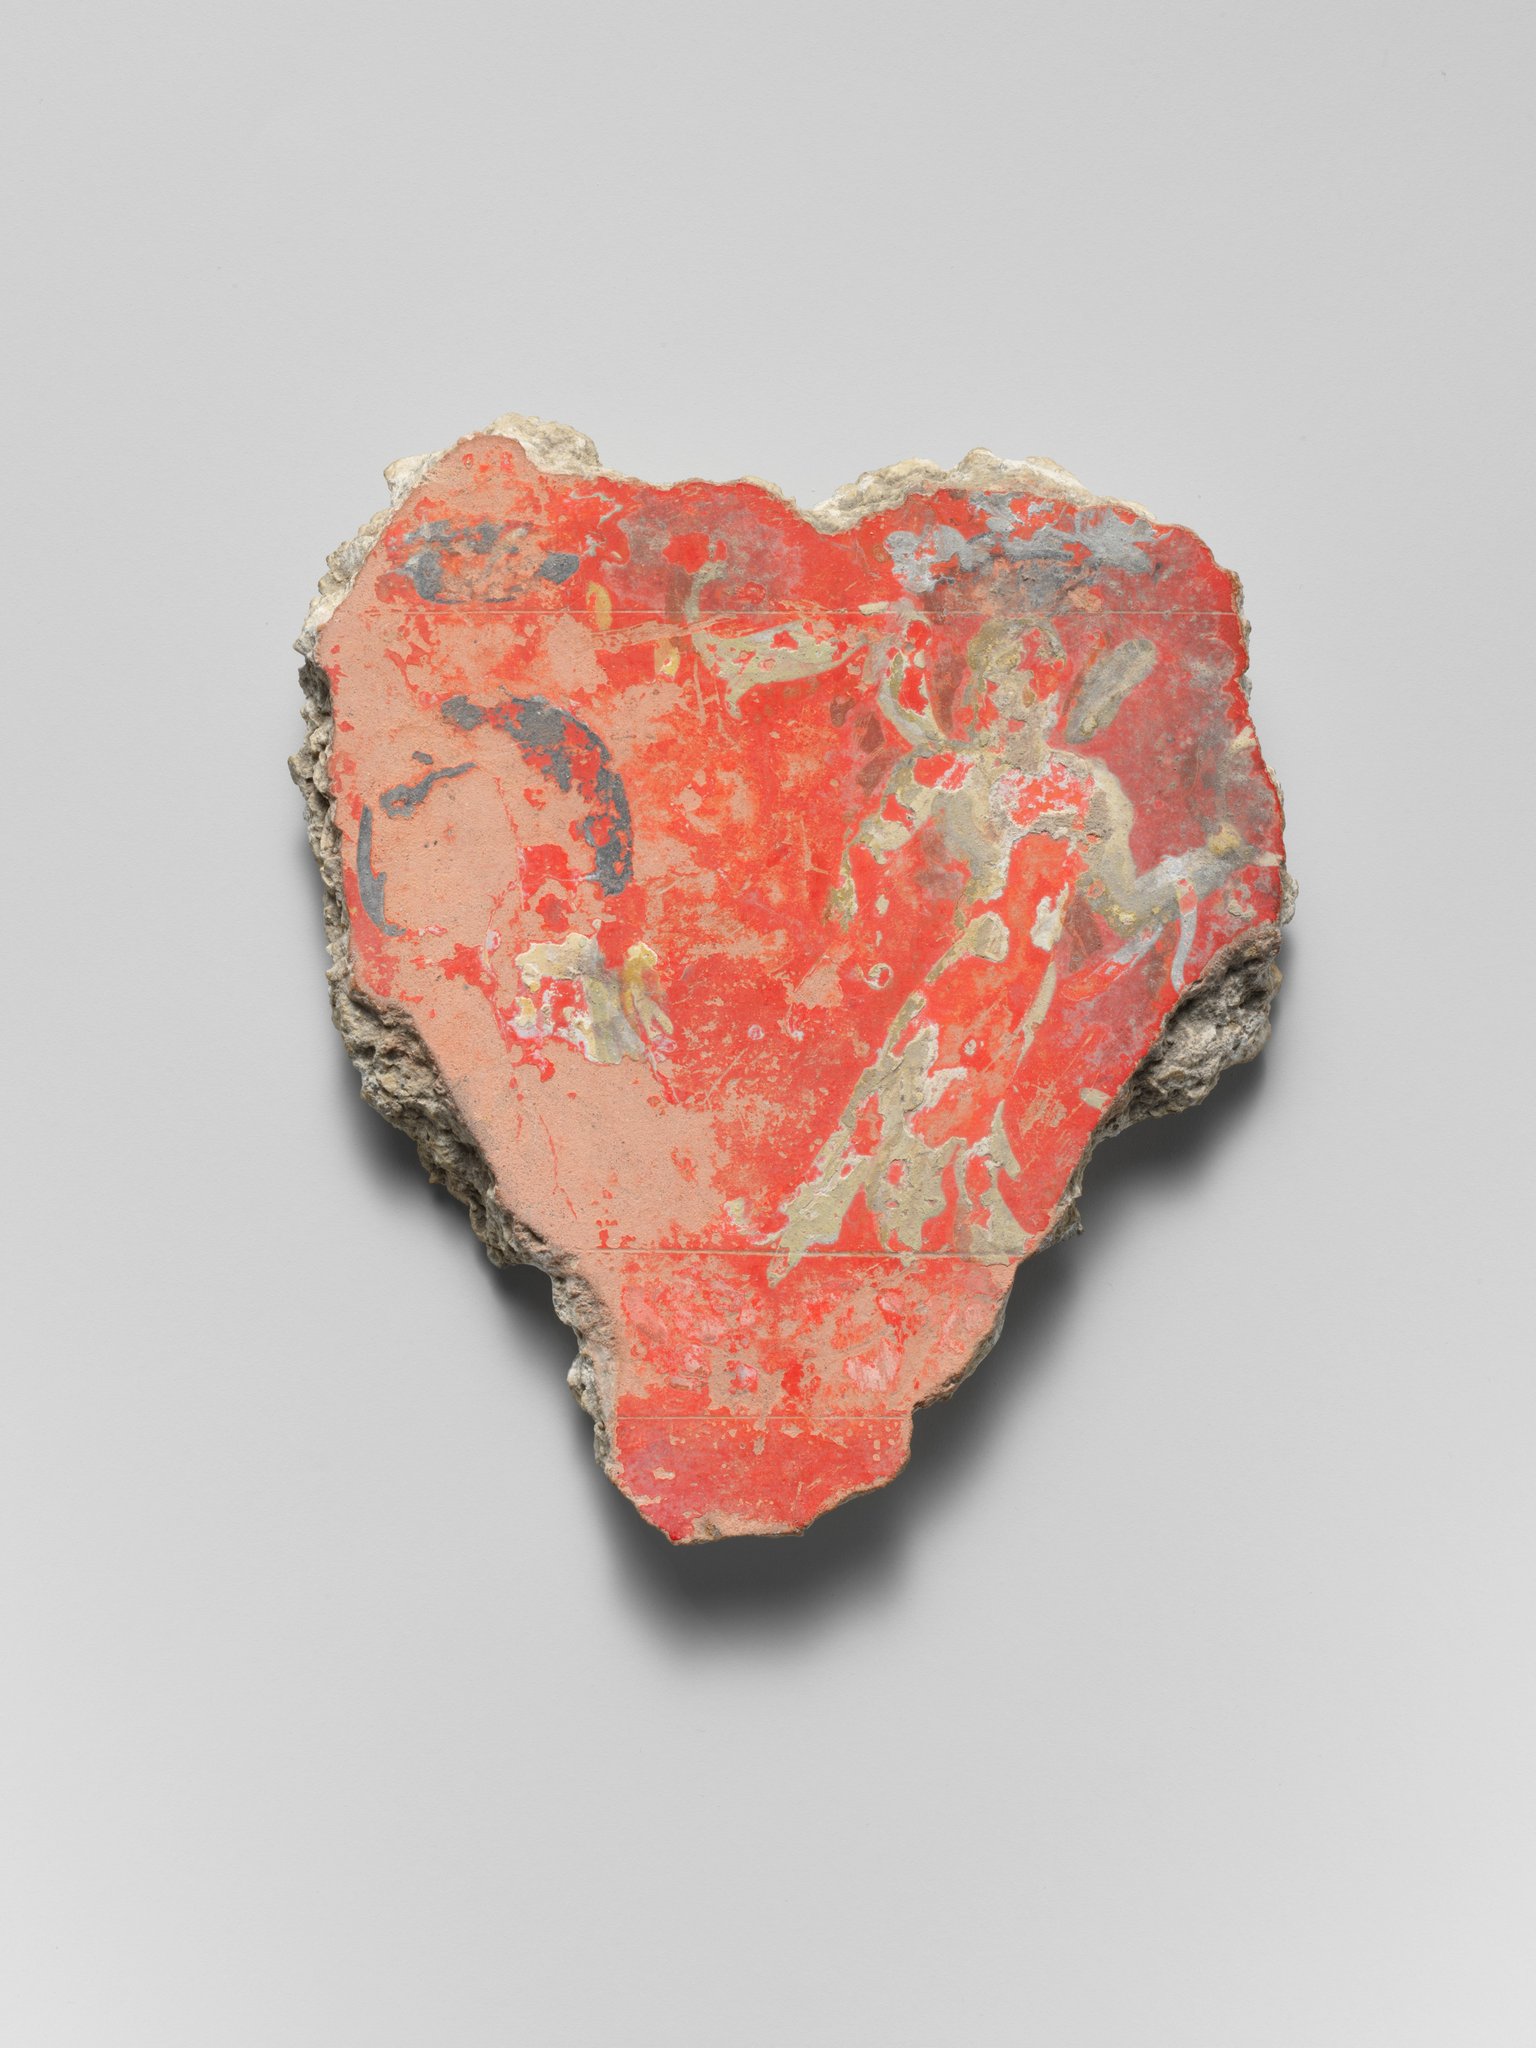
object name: wall painting fragment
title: Fresco fragment with siren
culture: roman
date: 1-100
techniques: fresco